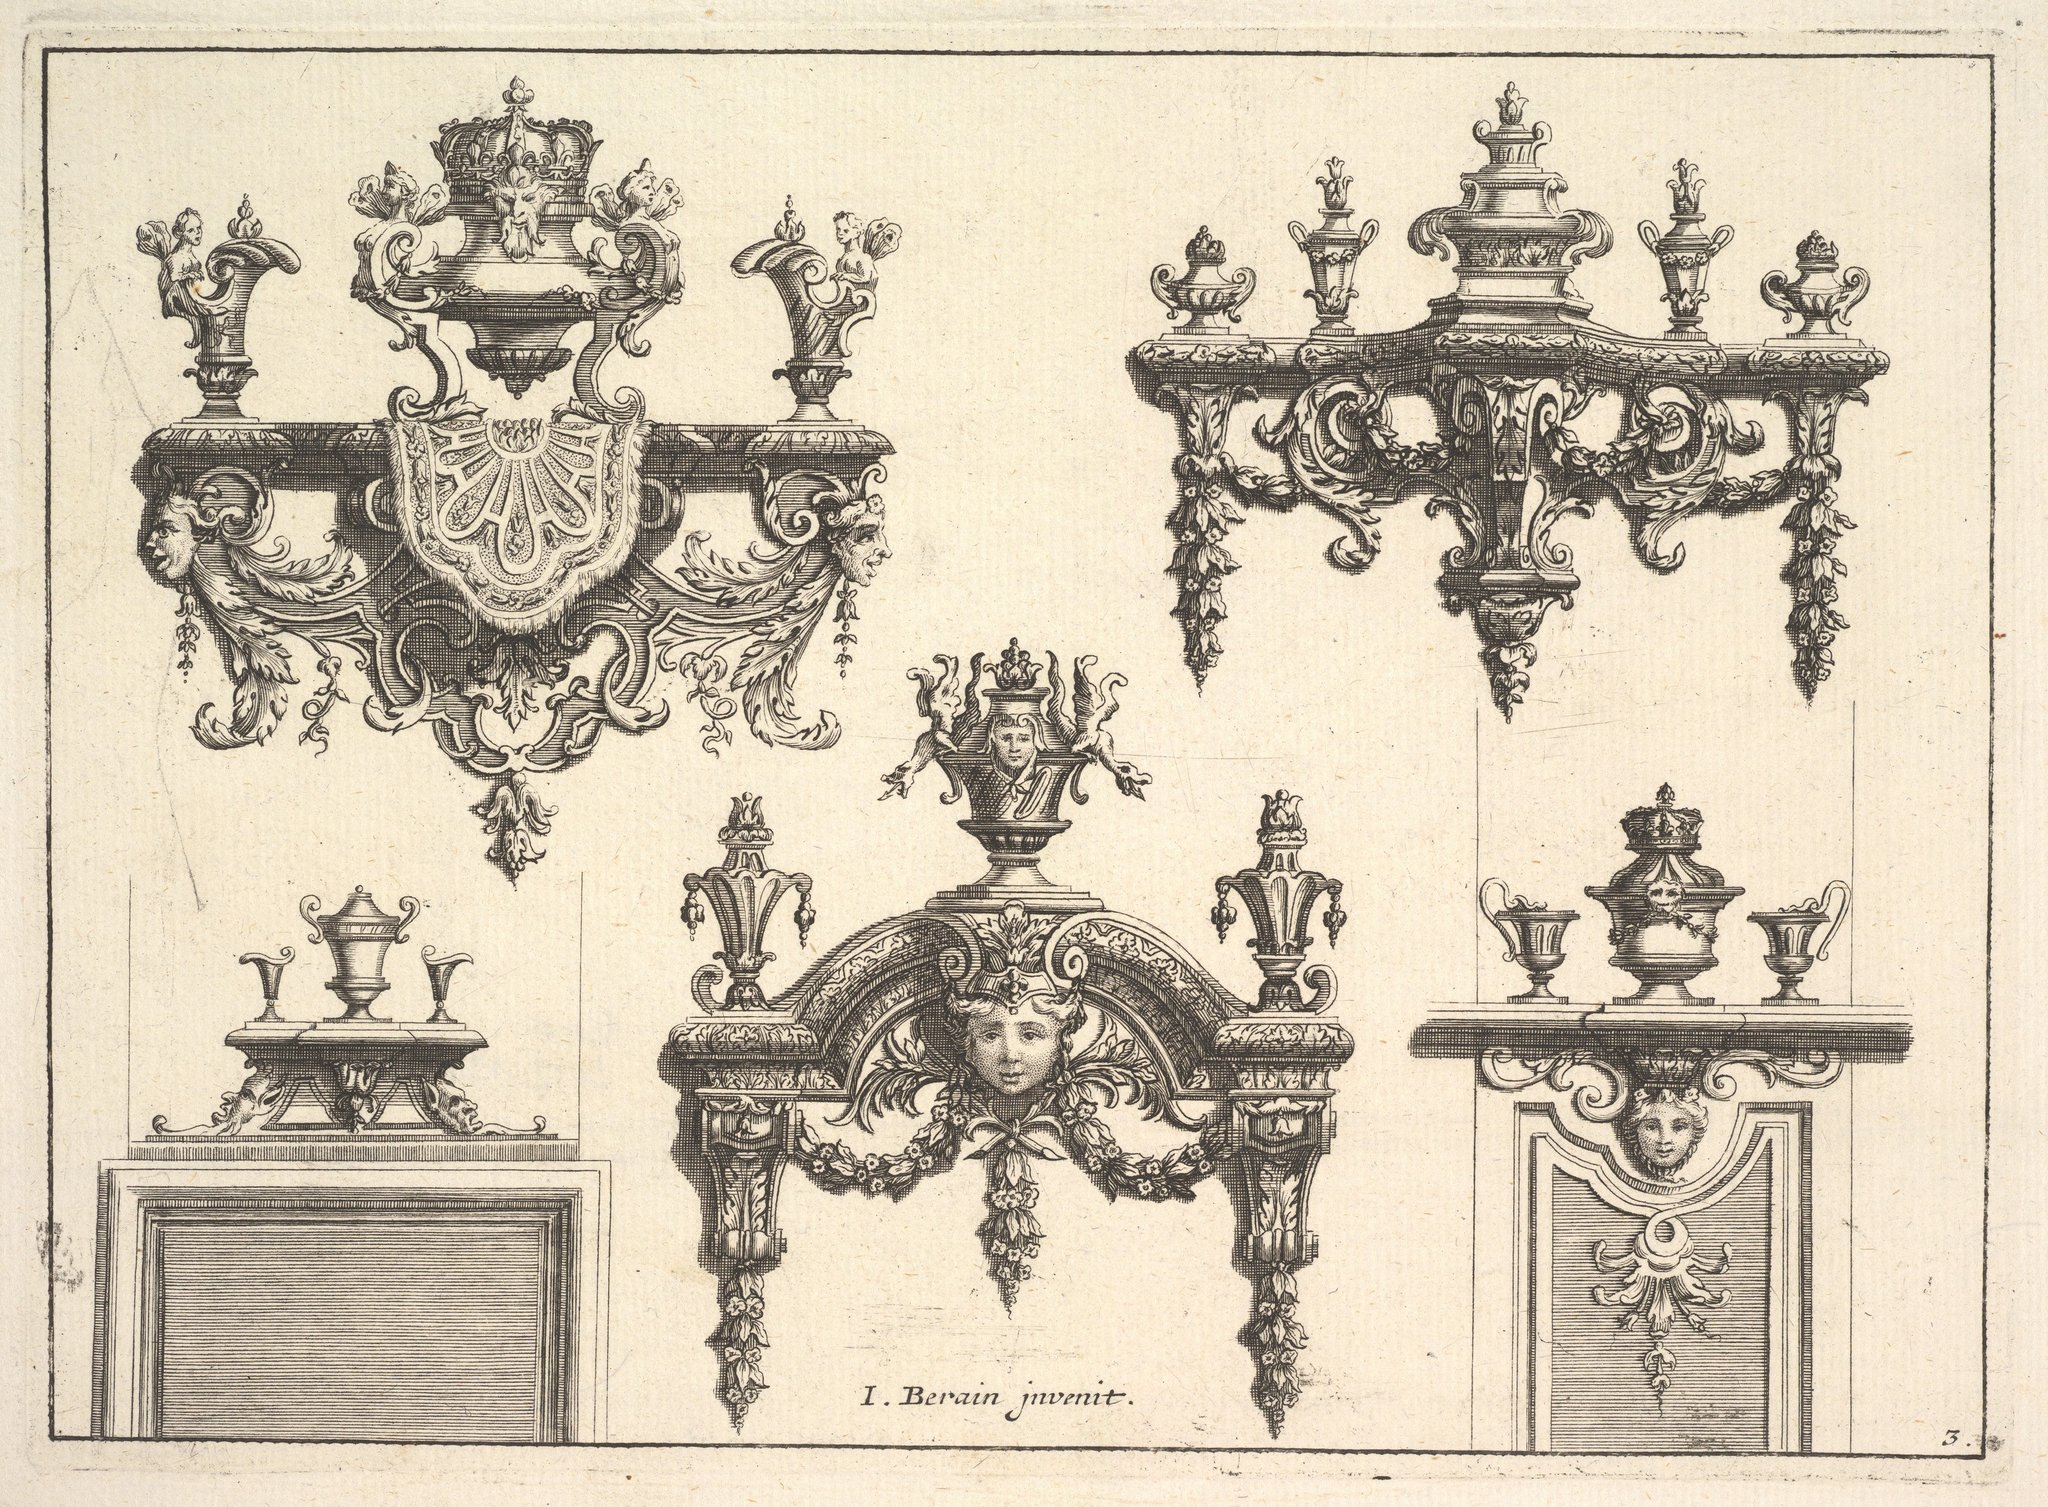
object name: print ornament architecture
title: Designs for Brackets with Silverwork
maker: jean berain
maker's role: artist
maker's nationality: french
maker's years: 1640-1711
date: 1667-1700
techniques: engraving, etching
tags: garlands,ornament,mythical creatures,furniture,vases